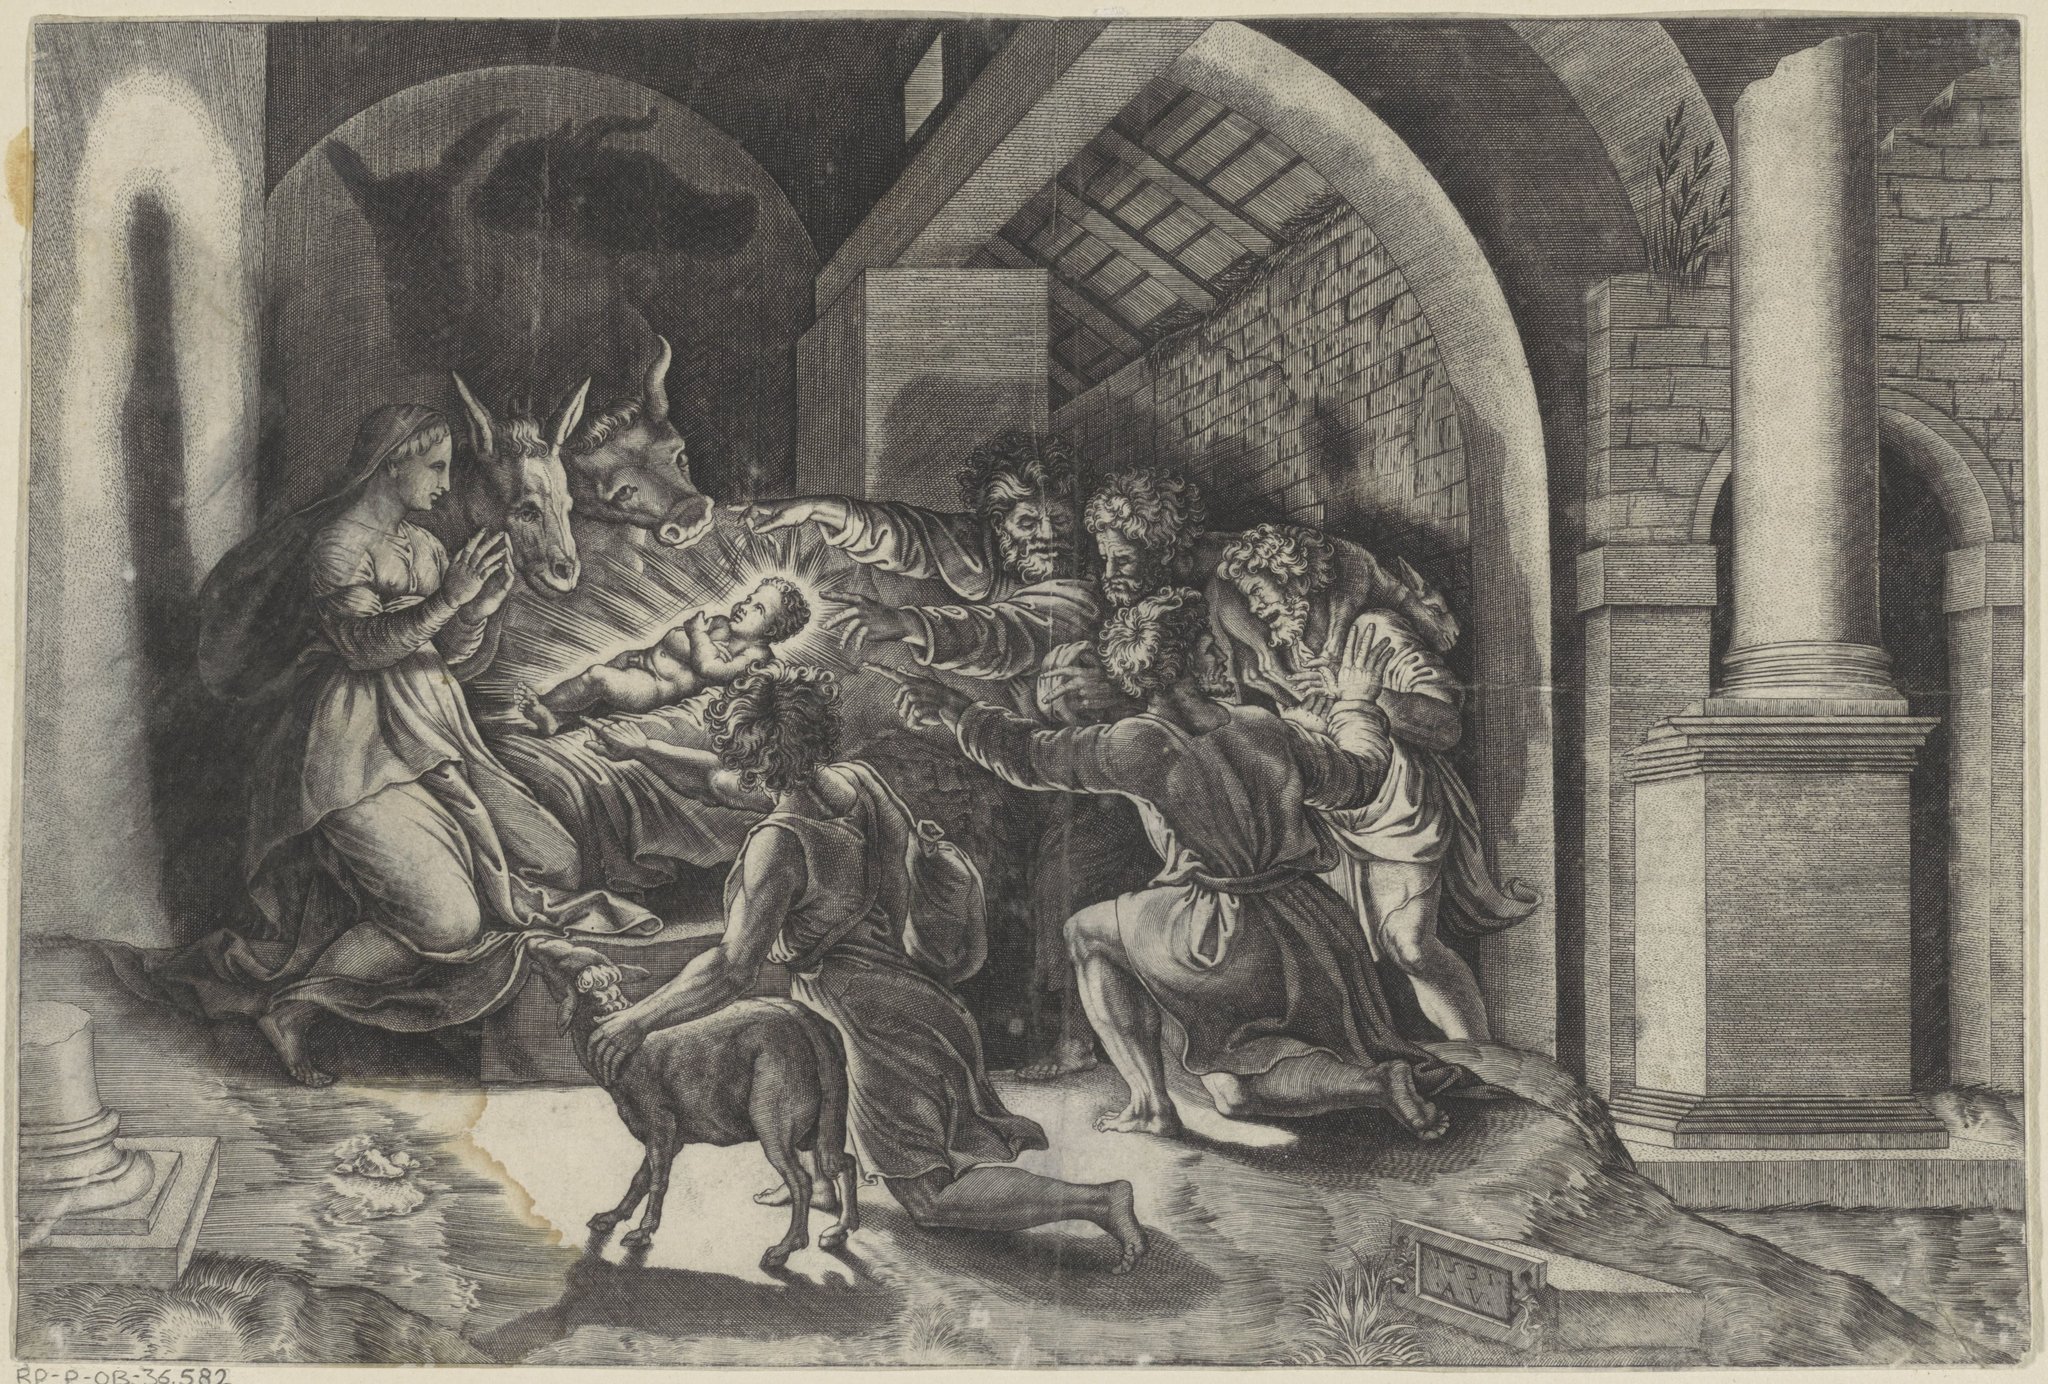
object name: print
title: Aanbidding door de herders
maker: agostino veneziano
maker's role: draughtsman, painter, print maker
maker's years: 1490-1536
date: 1531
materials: paper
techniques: engraving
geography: italy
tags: adoration of the christ-child by the shepherds; mary and joseph present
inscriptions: collector's mark: Lugt 240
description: In een open stal zit Maria geknield voor het Christuskind. Naast haar de os en de ezel. Rechts Jozef die de herders het kind toont.